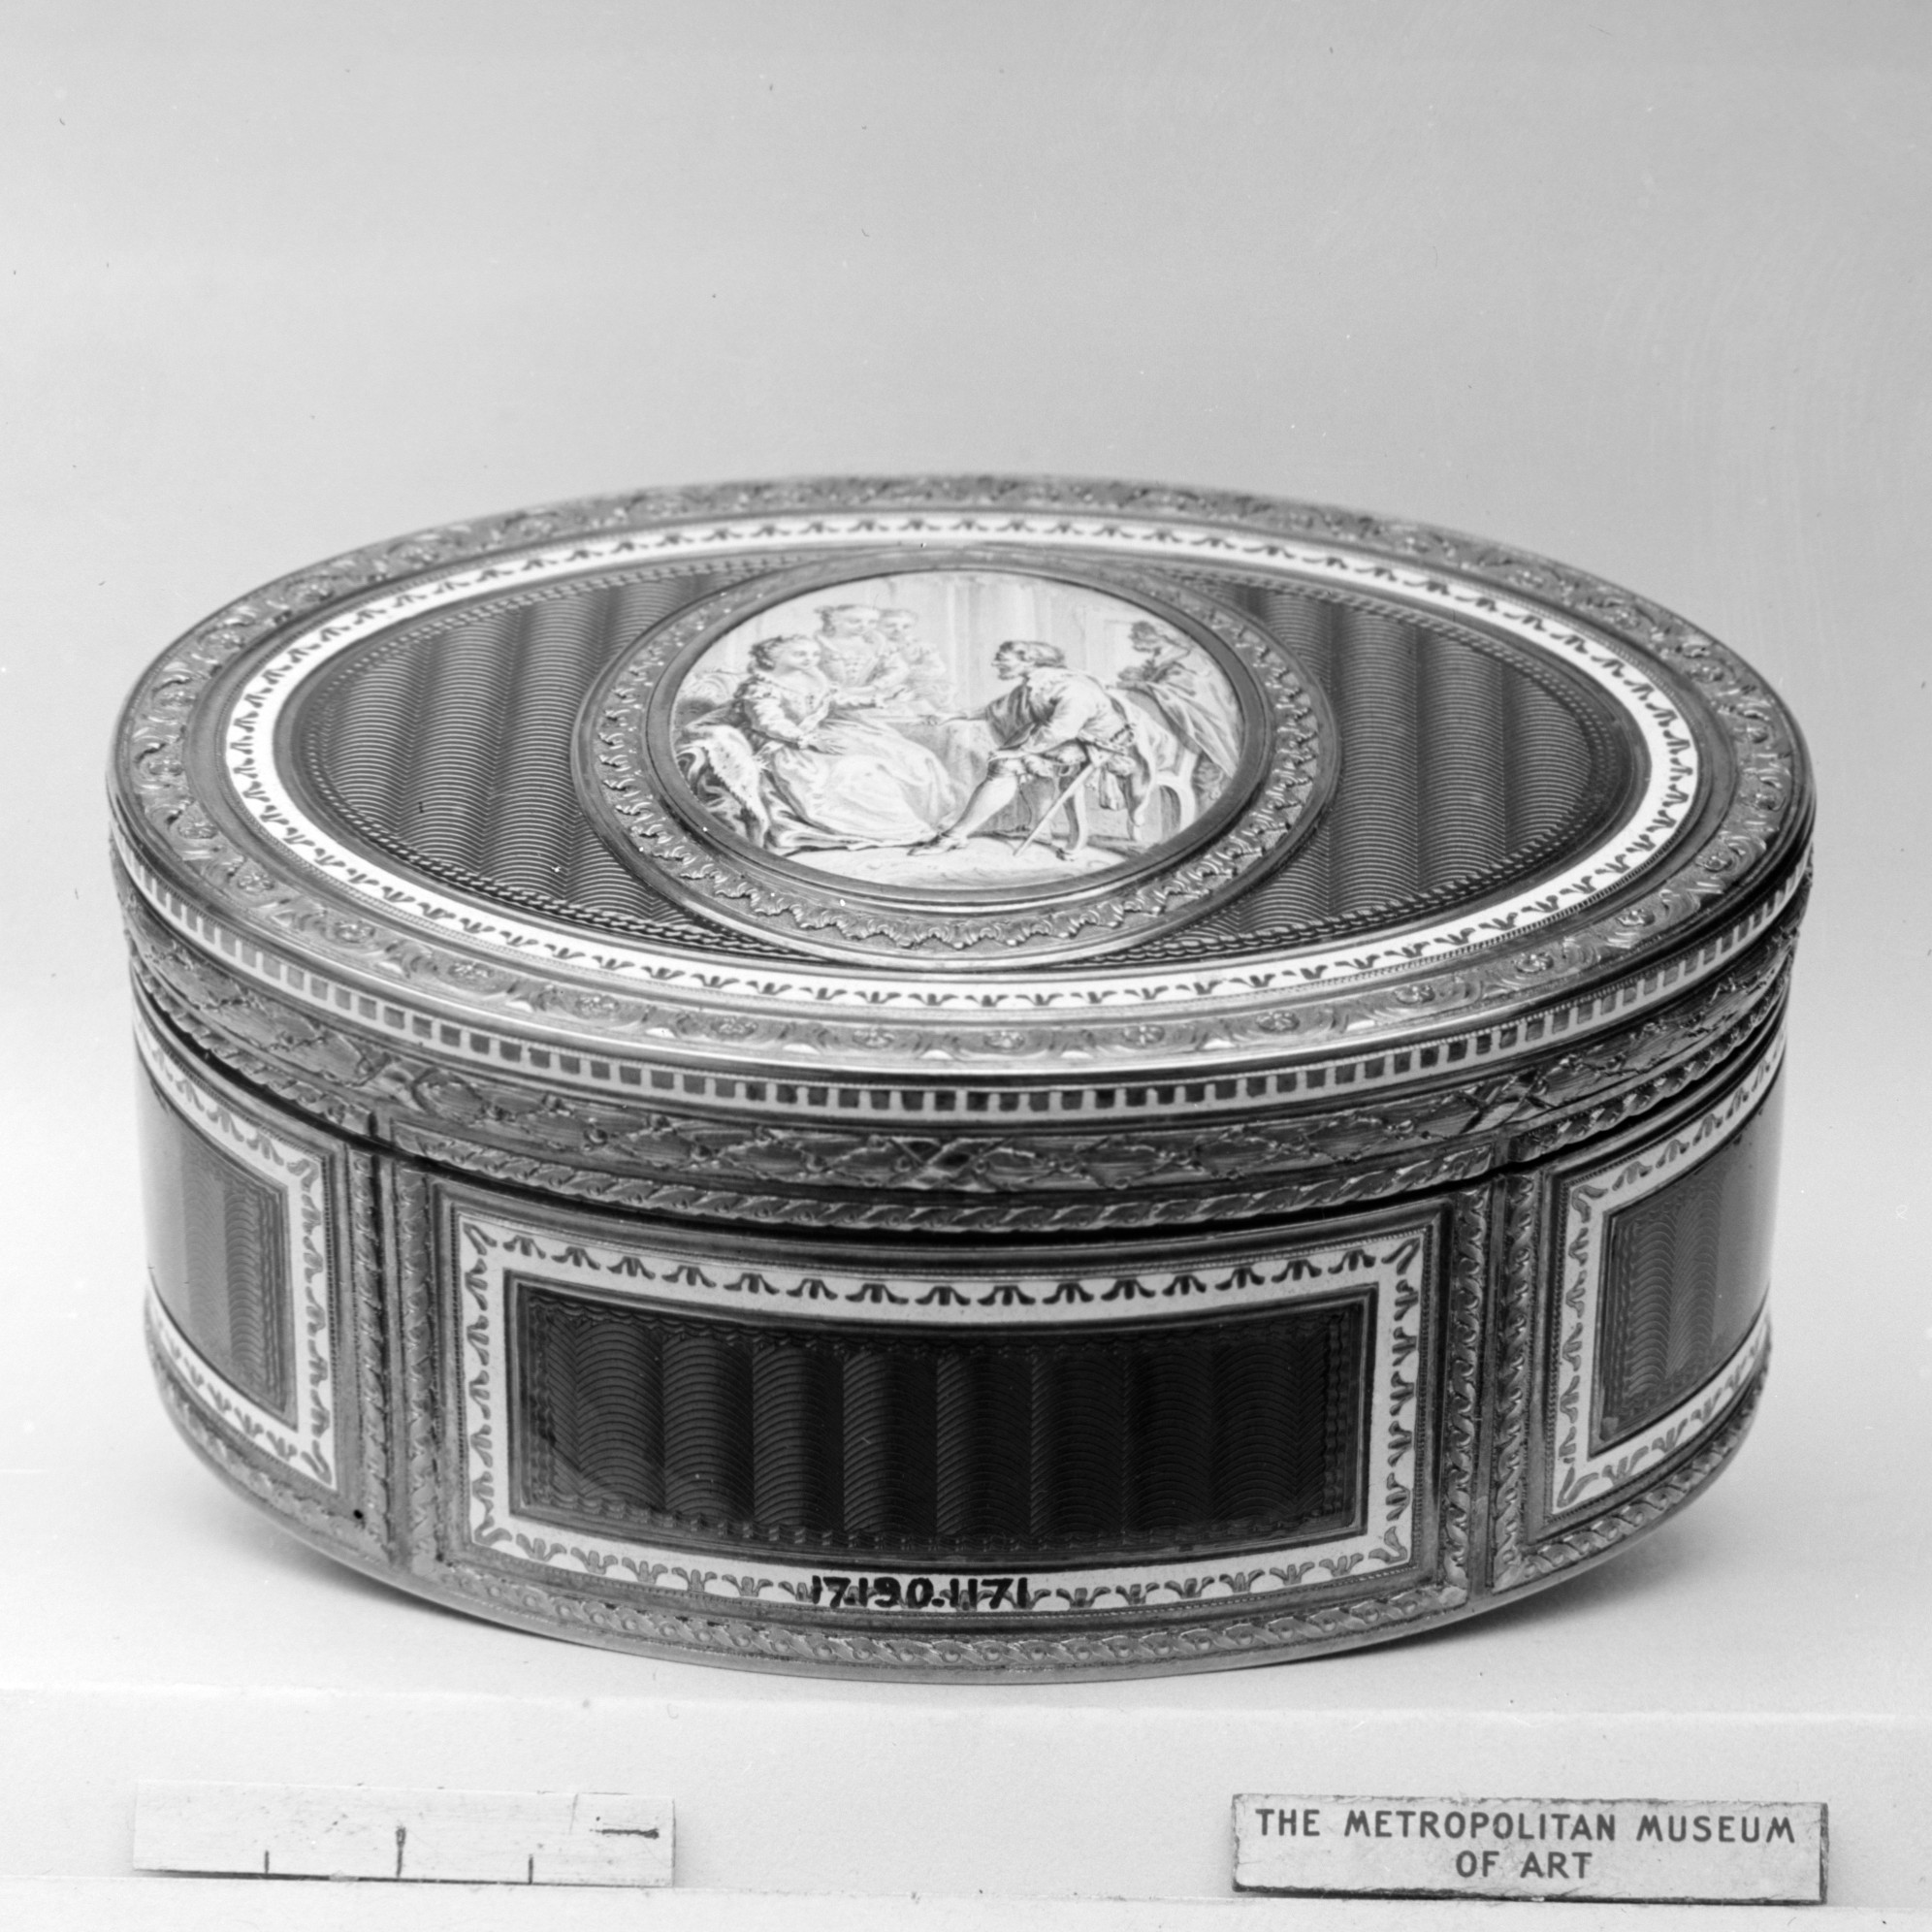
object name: snuffbox, painting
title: Snuffbox with grisaille miniature of scene from Don Quixote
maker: joseph etienne blerzy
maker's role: maker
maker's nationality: french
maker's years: 1750-1806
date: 1774-1775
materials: enamel, gold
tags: men,women,don quixote